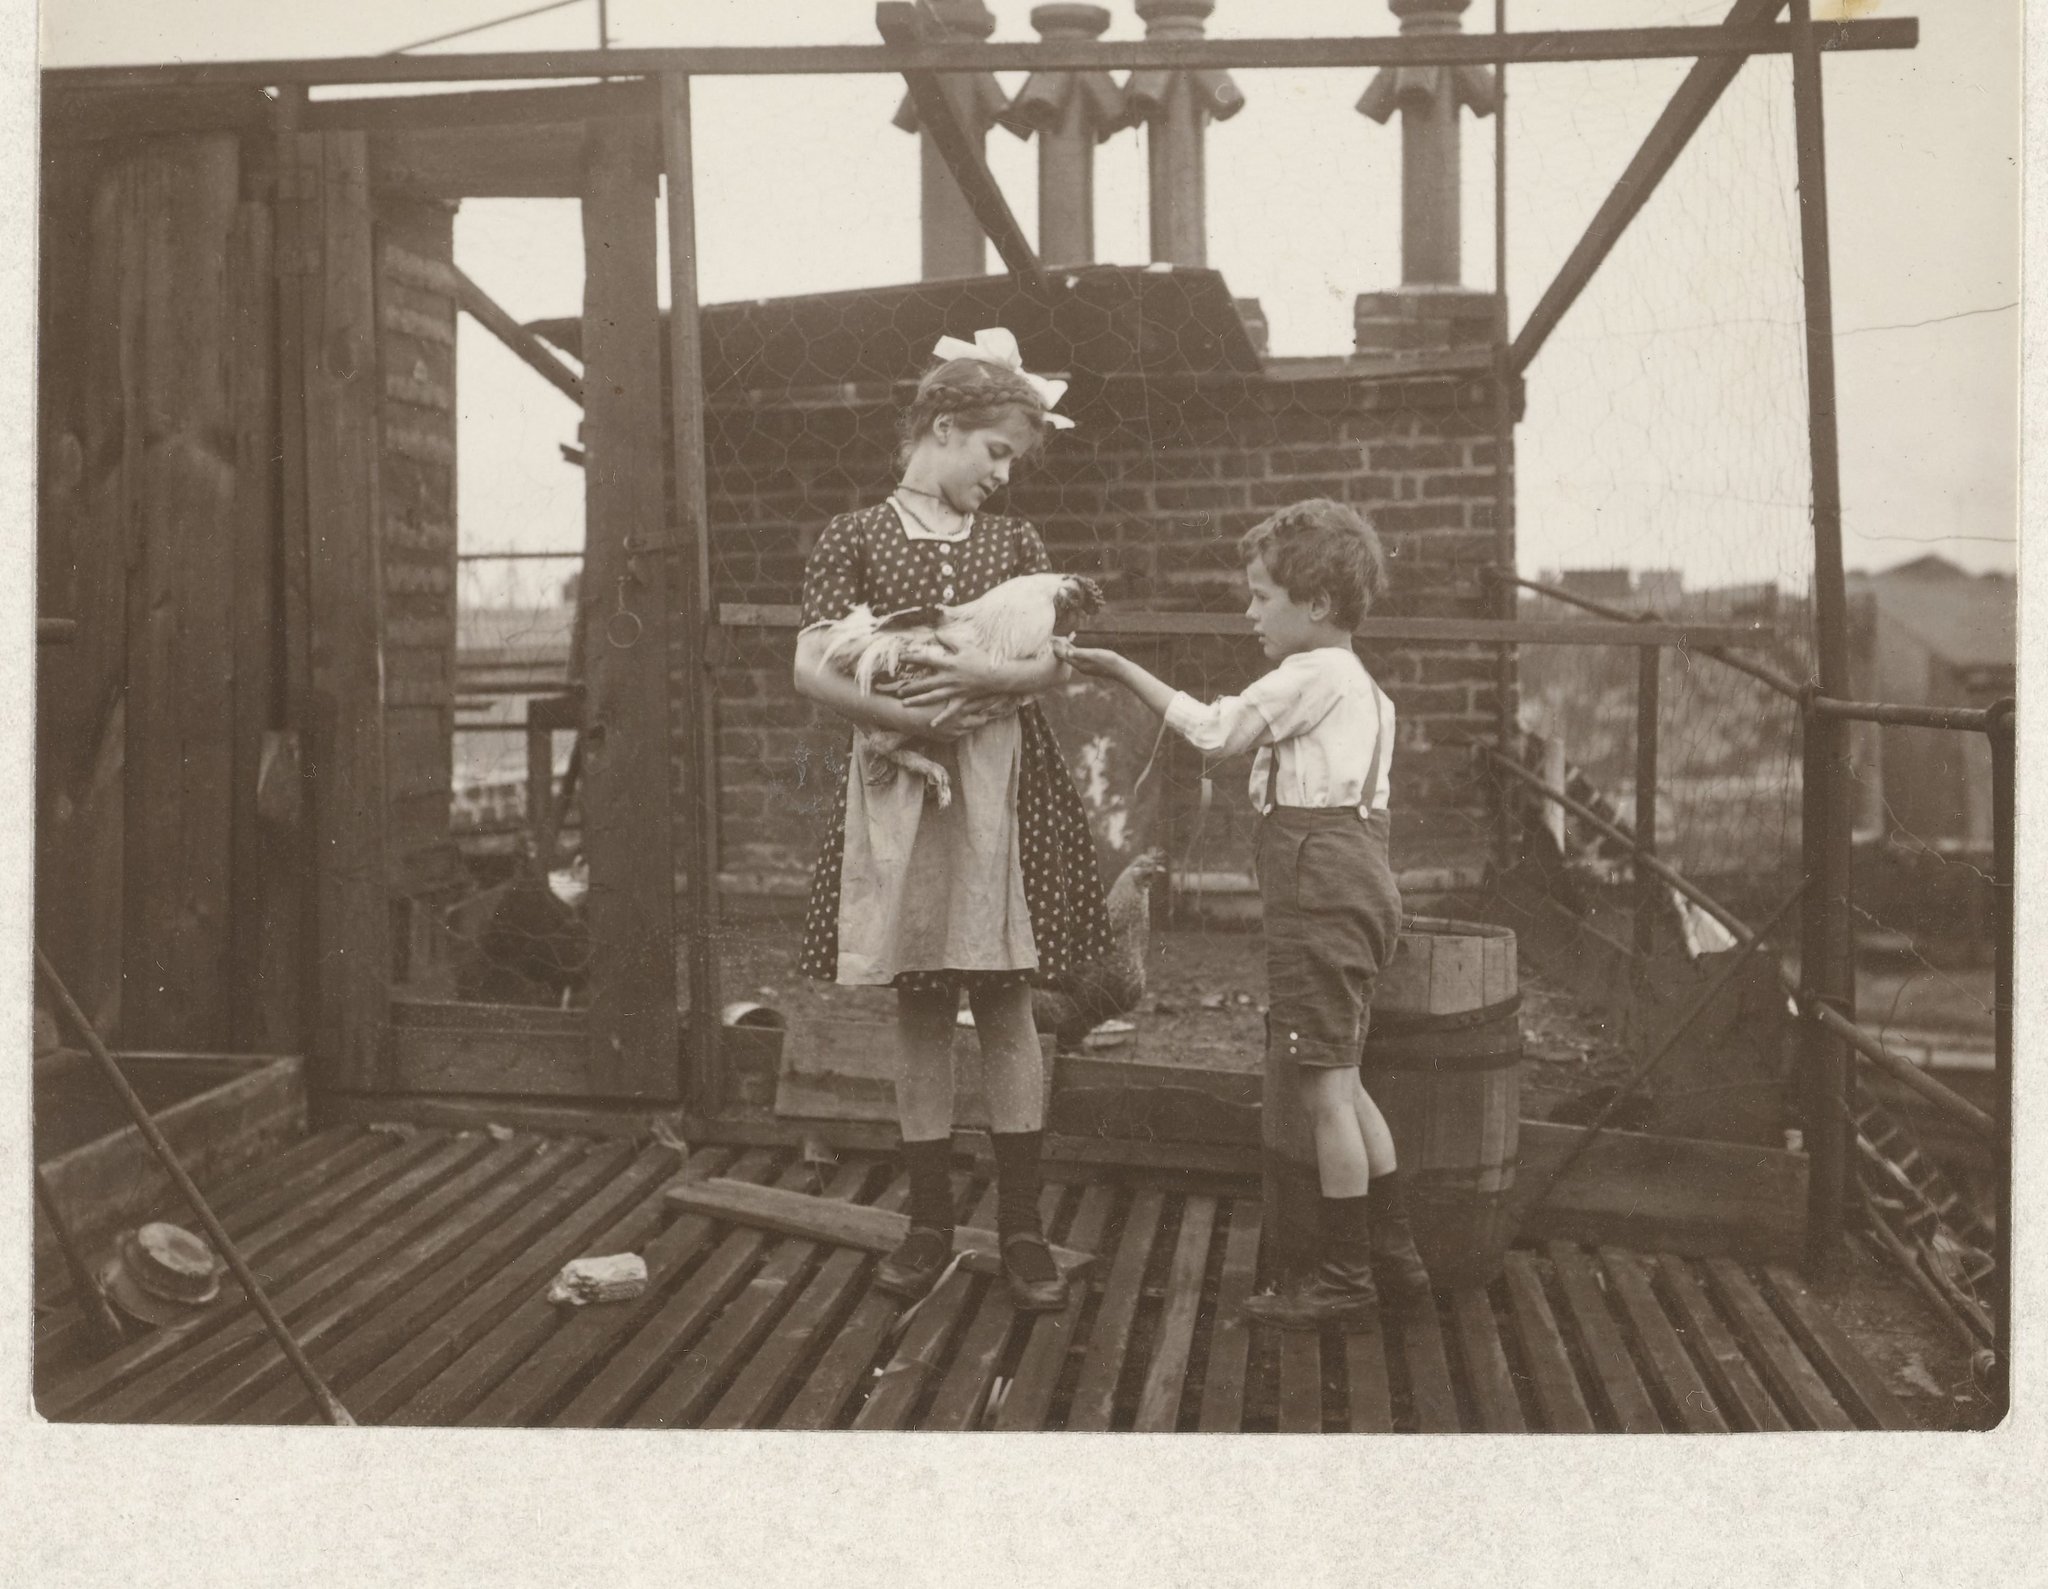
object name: photograph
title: Marba en Eckart Titzenthaler, kinderen van de fotograaf, met haan op het dakterras van het woonhuis in de Friedrichstrasse, Berlijn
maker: waldemar titzenthaler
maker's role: fotograaf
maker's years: 1869-1937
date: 1918-1920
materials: paper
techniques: gelatin silver print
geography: berlin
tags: berlin, engineer, boy (child between toddler and youth), roof garden, girl (child between toddler and youth), fowl (cock, hen, chicken, etc.)